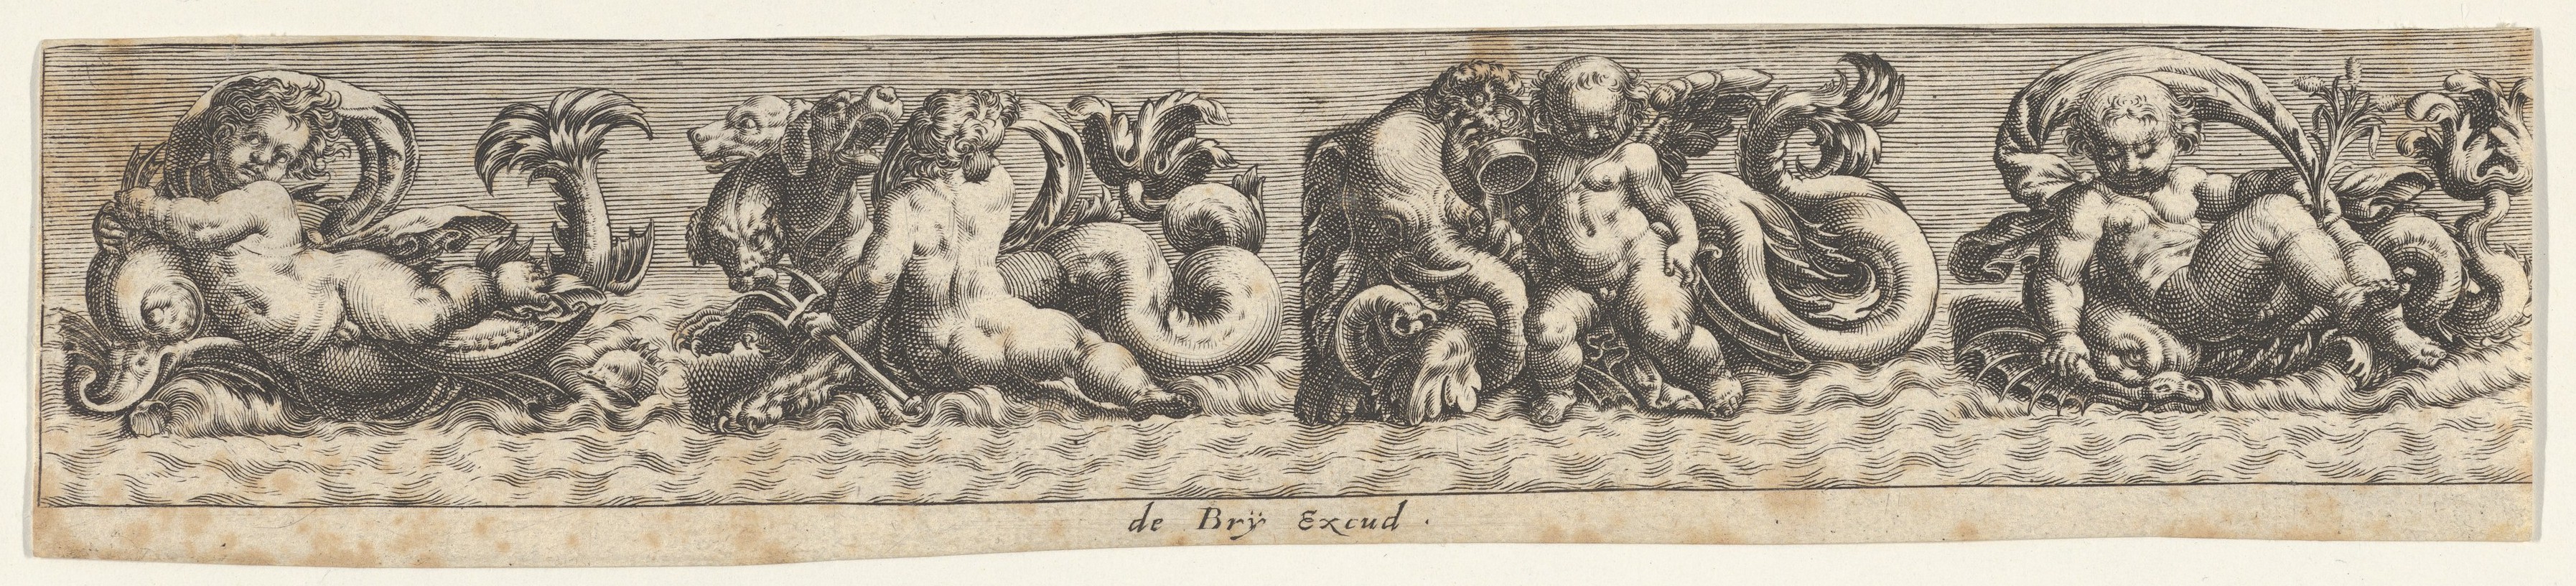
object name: print ornament architecture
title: Frieze with Sea Monsters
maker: johann theodor de bry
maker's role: artist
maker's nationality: netherlandish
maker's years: 1561-1623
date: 1580-1600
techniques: engraving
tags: mythical creatures,putti